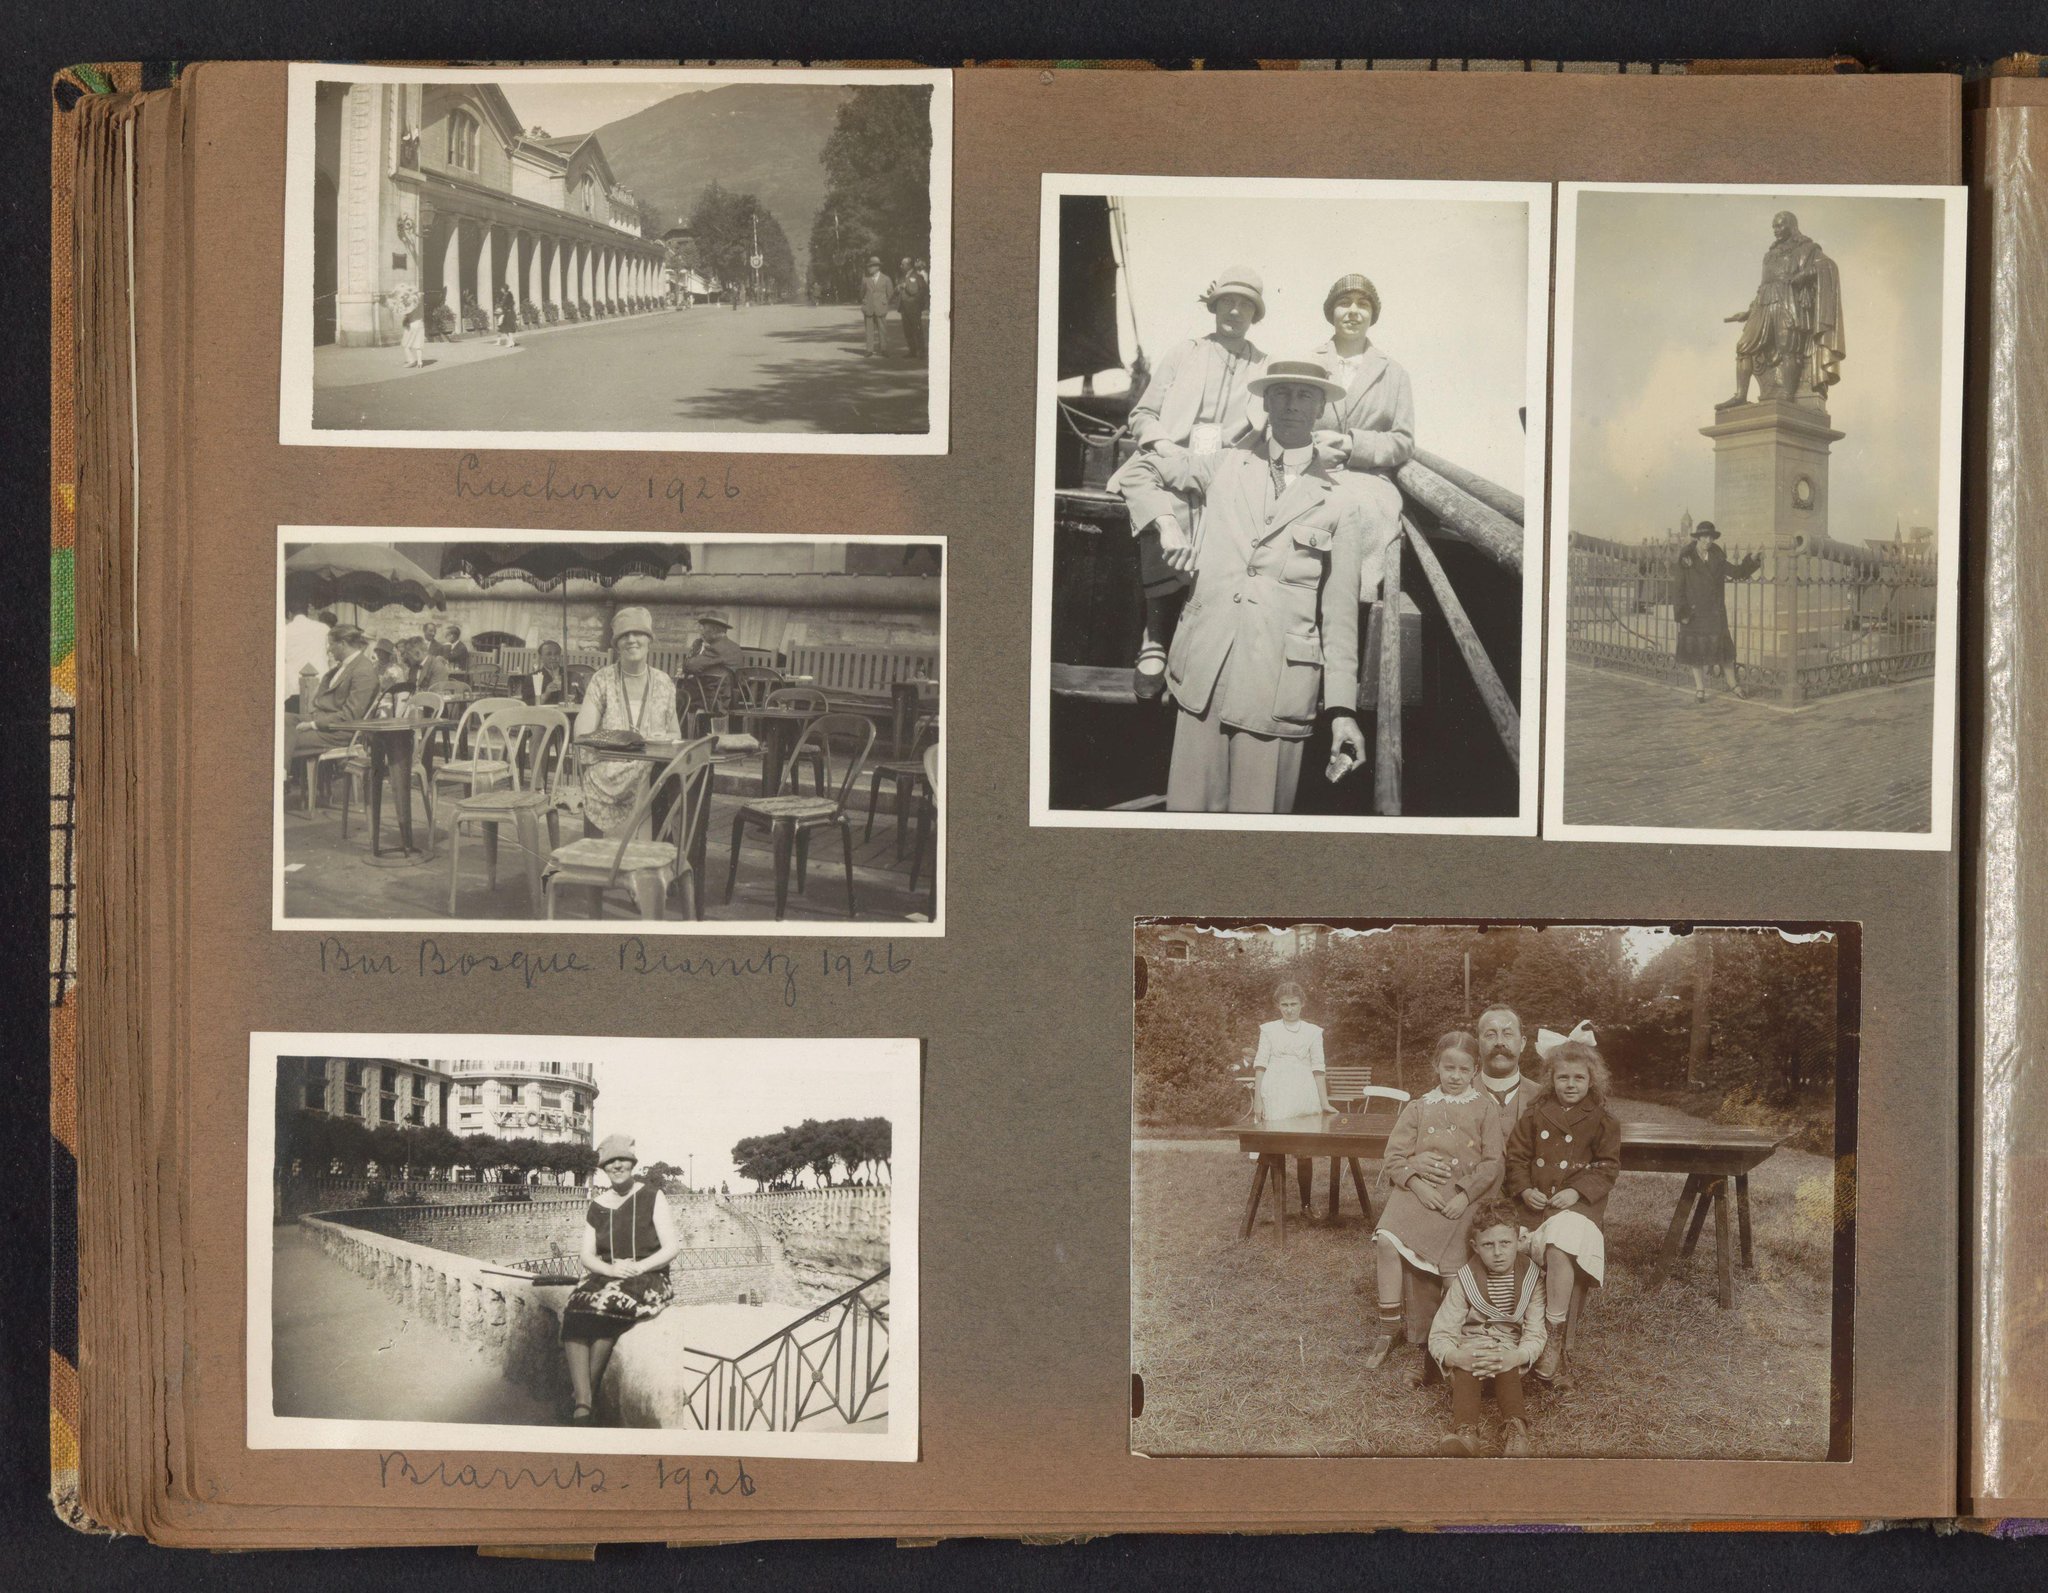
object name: album leaf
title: Verblijf in Biarrritz, Luchon en MIddelburg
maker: Anonymous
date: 1900-1926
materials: cardboard, photographic support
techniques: gelatin silver print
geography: biarritz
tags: adult woman, adult man, monument, statue, middelburg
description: Albumblad met foto's van het badgebouw van Luchon, van een vrouw op het terras van Bar Bosque in Biarritz en op een muur in dezelfde stad. Ook een foto van een vrouw poserend voor het standbeeld van Michiel de Ruyter in Middelburg en van een man met drie kinderen. Onderdeel van Fotoalbum van een onbekende Nederlandse familie met connecties in Suriname en Nederlands-Indië (2).